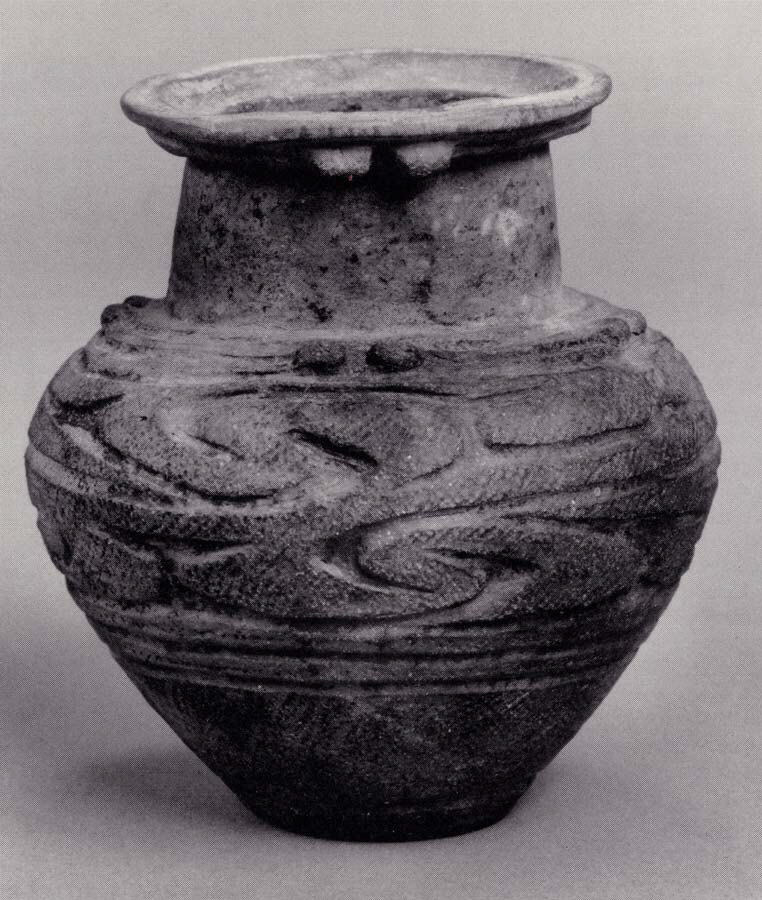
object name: vessel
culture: japanese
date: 500 BCE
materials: earthenware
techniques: incising